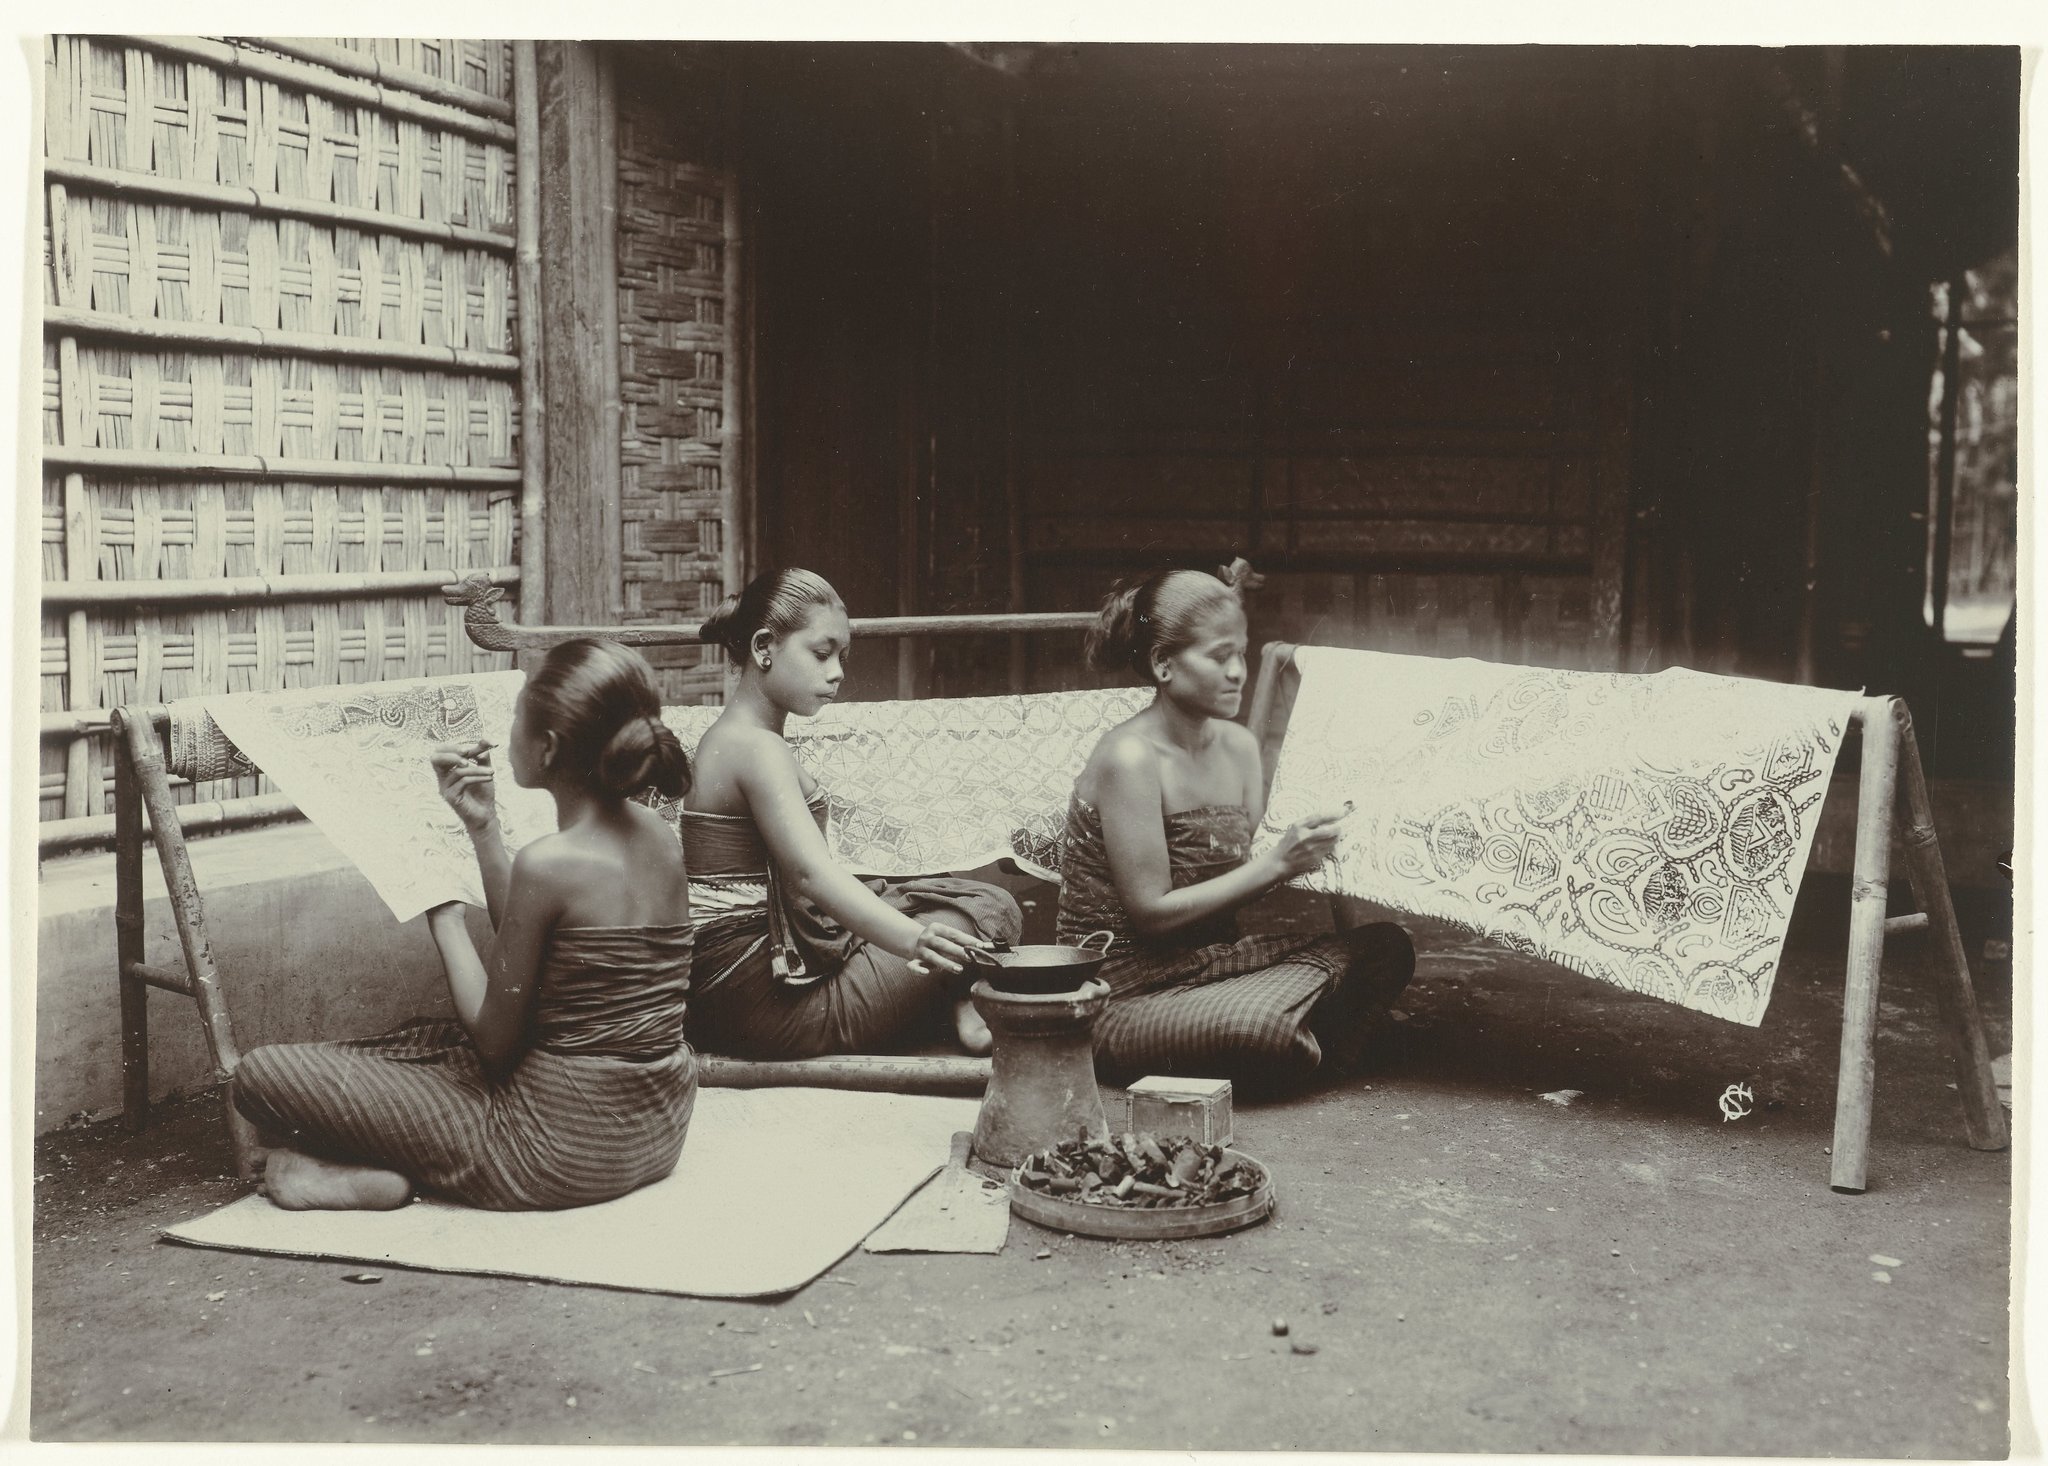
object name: photograph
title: Three Javanese Women Drawing Batik Designs on Cloth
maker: kassian céphas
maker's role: fotograaf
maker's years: 1845-1912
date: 1867-1910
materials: cardboard, paper, photographic support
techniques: albumen print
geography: java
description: This photograph has been carefully staged. Three women draw motifs on cotton fabric using molten wax. The wax is heated in a metal pan on a brazier. When the fabric is dyed, the wax motifs remain colour-free. Then the wax is melted away and the pattern emerges.